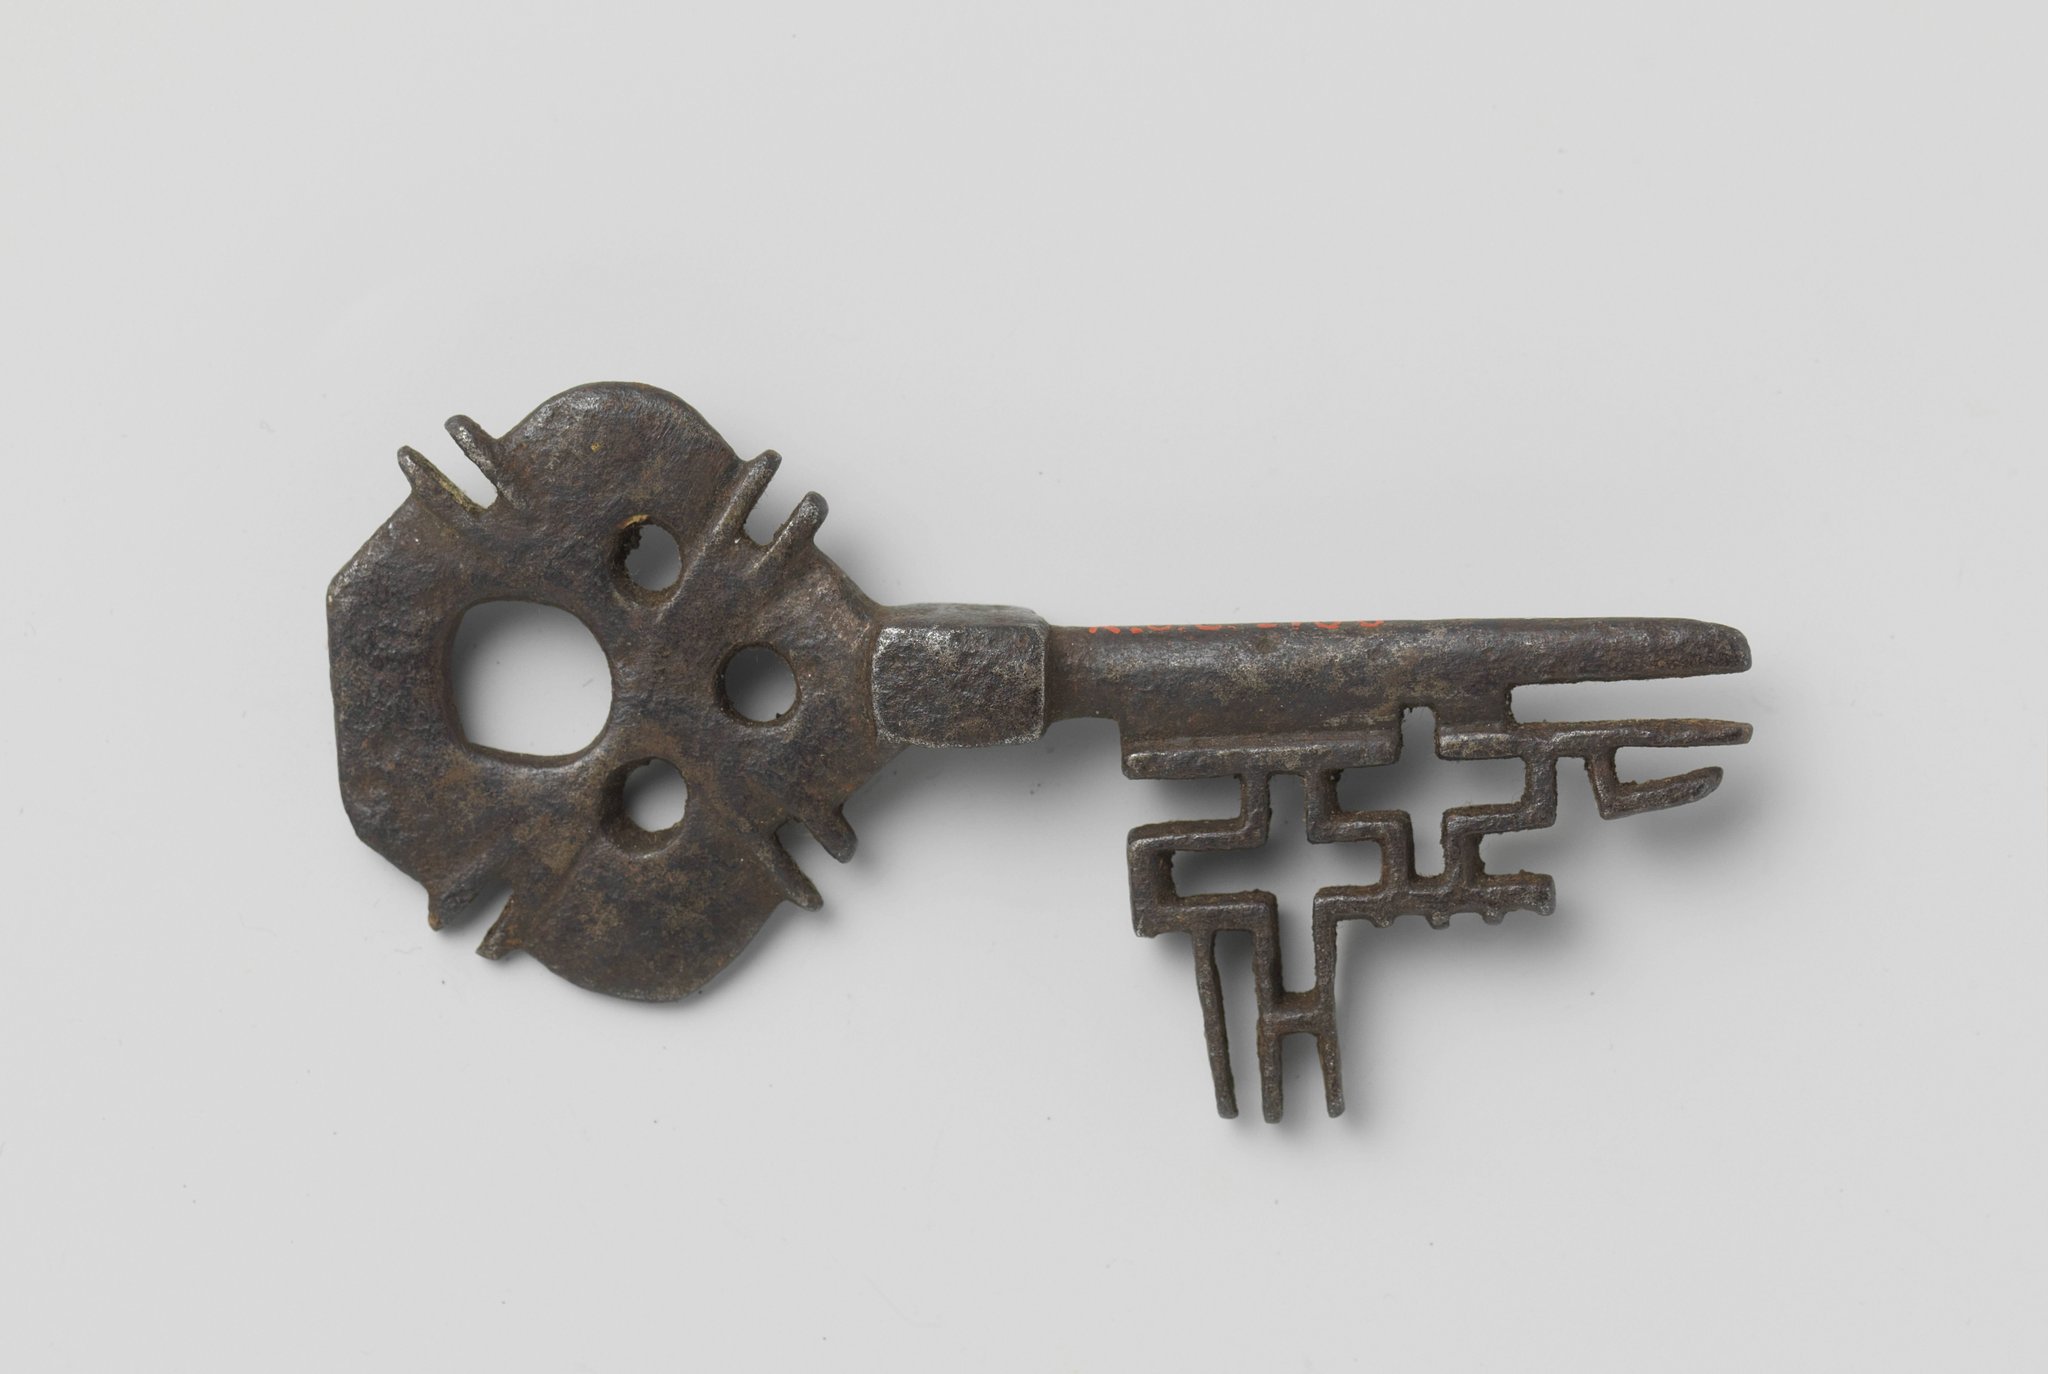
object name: key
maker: Anonymous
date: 1200-1400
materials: iron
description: Sleutel waarvan de greep lijkt op een vierbladig bloemmotief. De uitvoerig bewerkte baard is gedeeltelijk afgebroken.